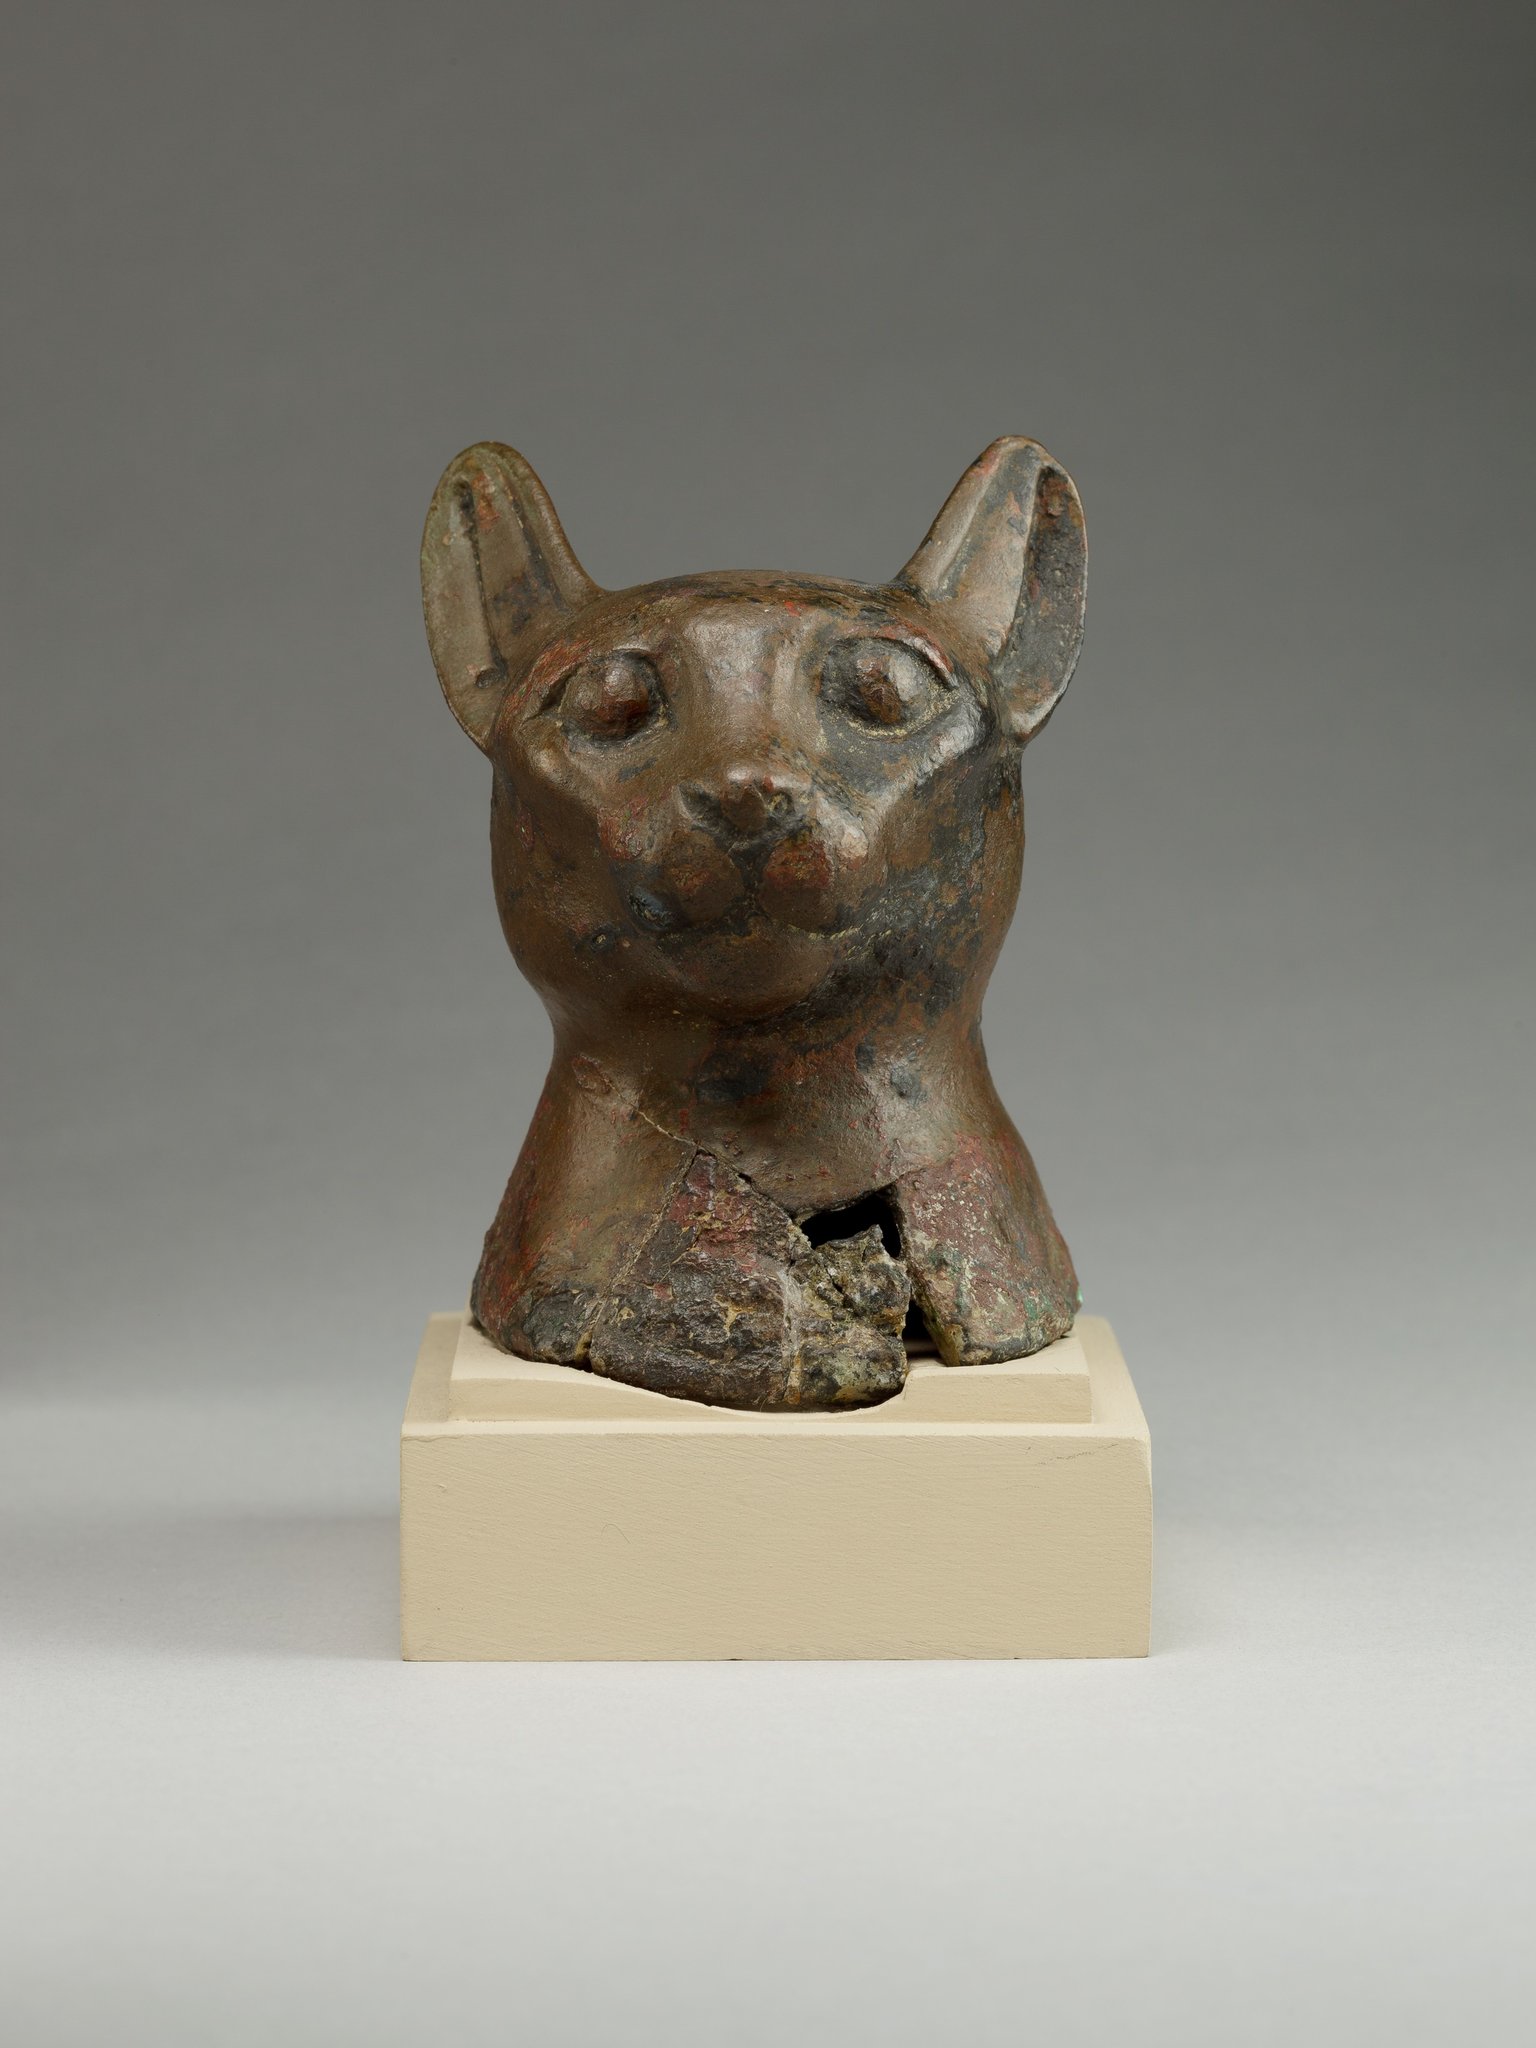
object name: head, cat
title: Head of a cat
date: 664-630 BCE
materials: metal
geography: egypt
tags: cats